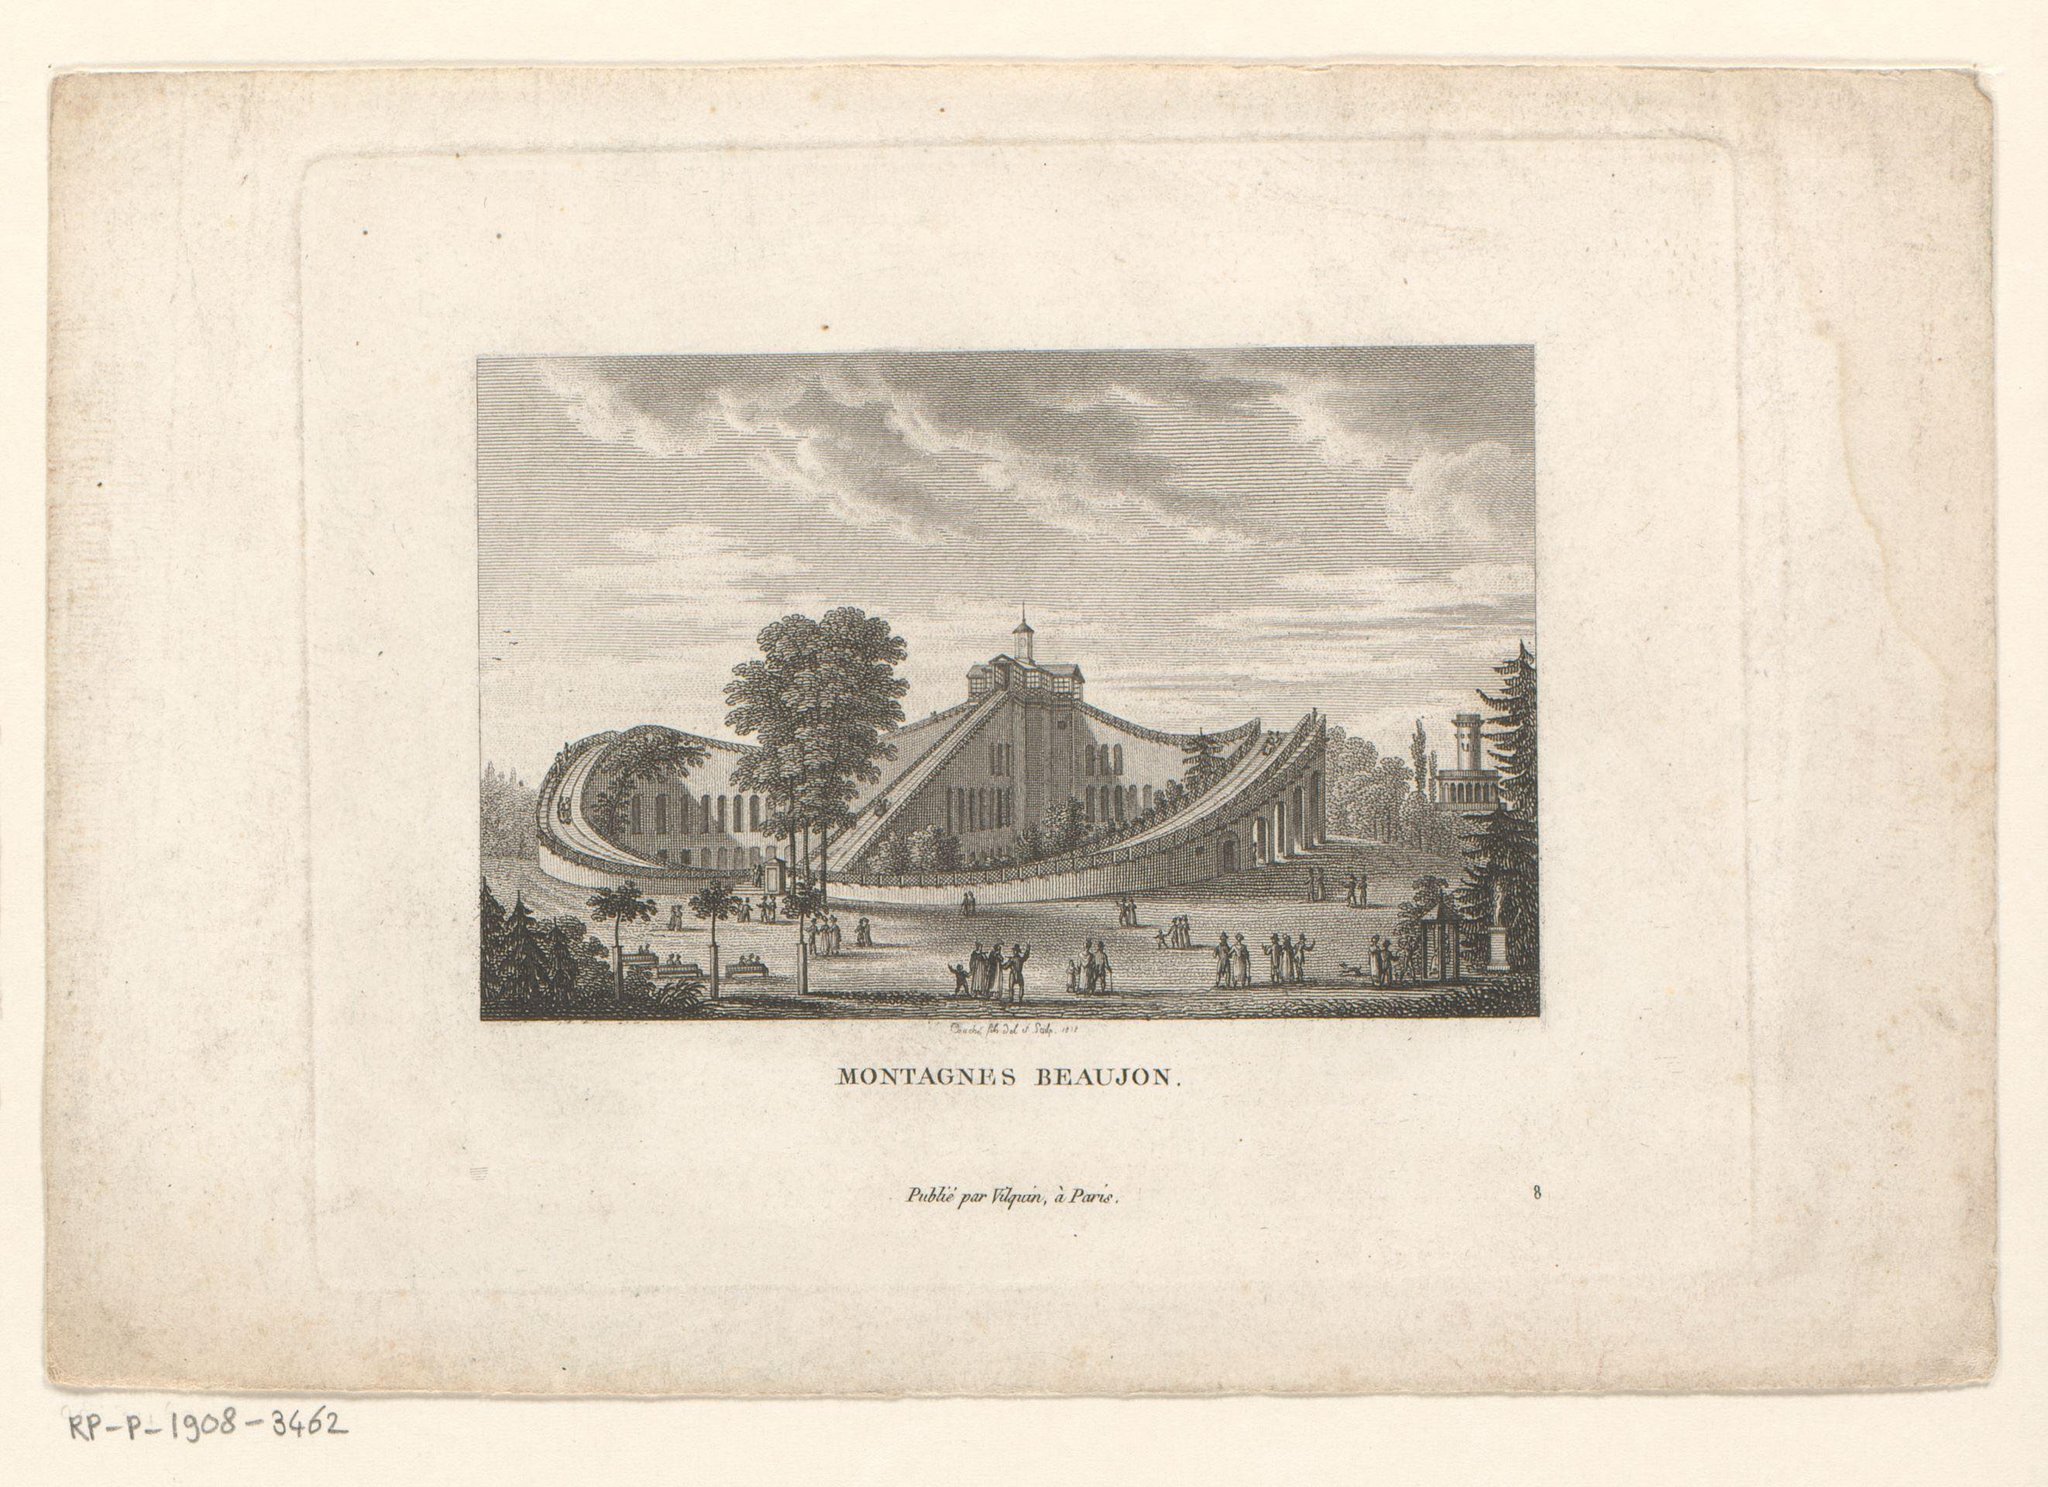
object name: print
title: Gezichten op Parijs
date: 1818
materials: paper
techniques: etching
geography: paris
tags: city-view in general; 'veduta', roller-coaster, pleasure fair and circus, paris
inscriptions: collector's mark: Lugt 2228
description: Maakt deel uit van een serie met 60 platen van monumenten, kathedralen en paleizen in Parijs.